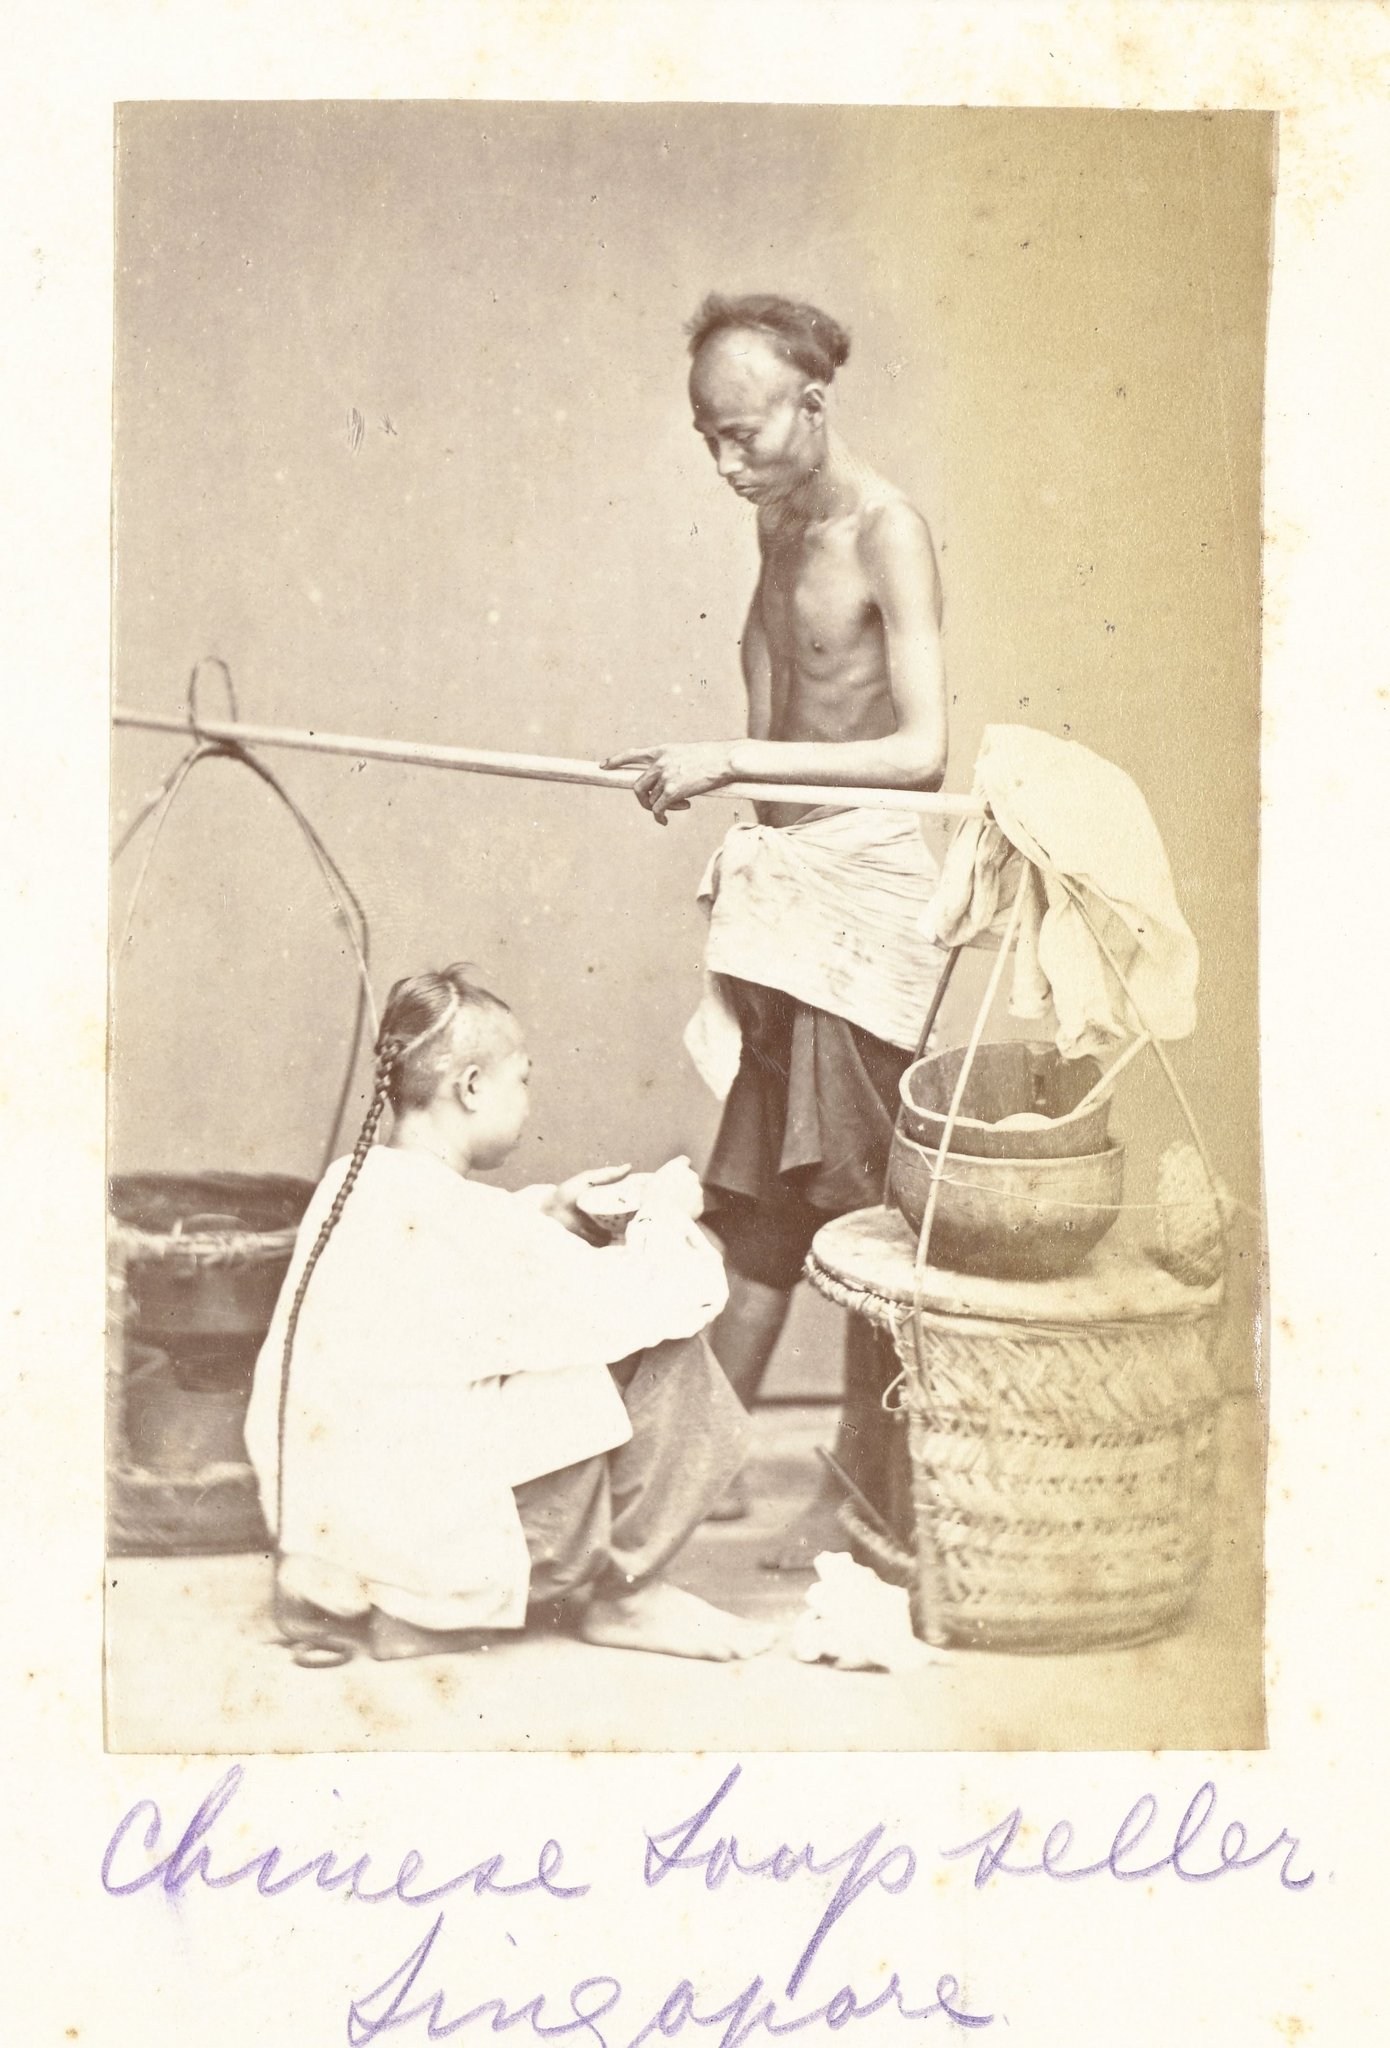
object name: photograph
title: Chinese straatvekoper van soep die zijn verkoopwaar meedraagt in rietenmanden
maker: Anonymous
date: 1890-1910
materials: cardboard, paper, photographic support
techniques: gelatin silver print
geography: singapore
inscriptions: caption: ‘Chinese soupseller Singapore’